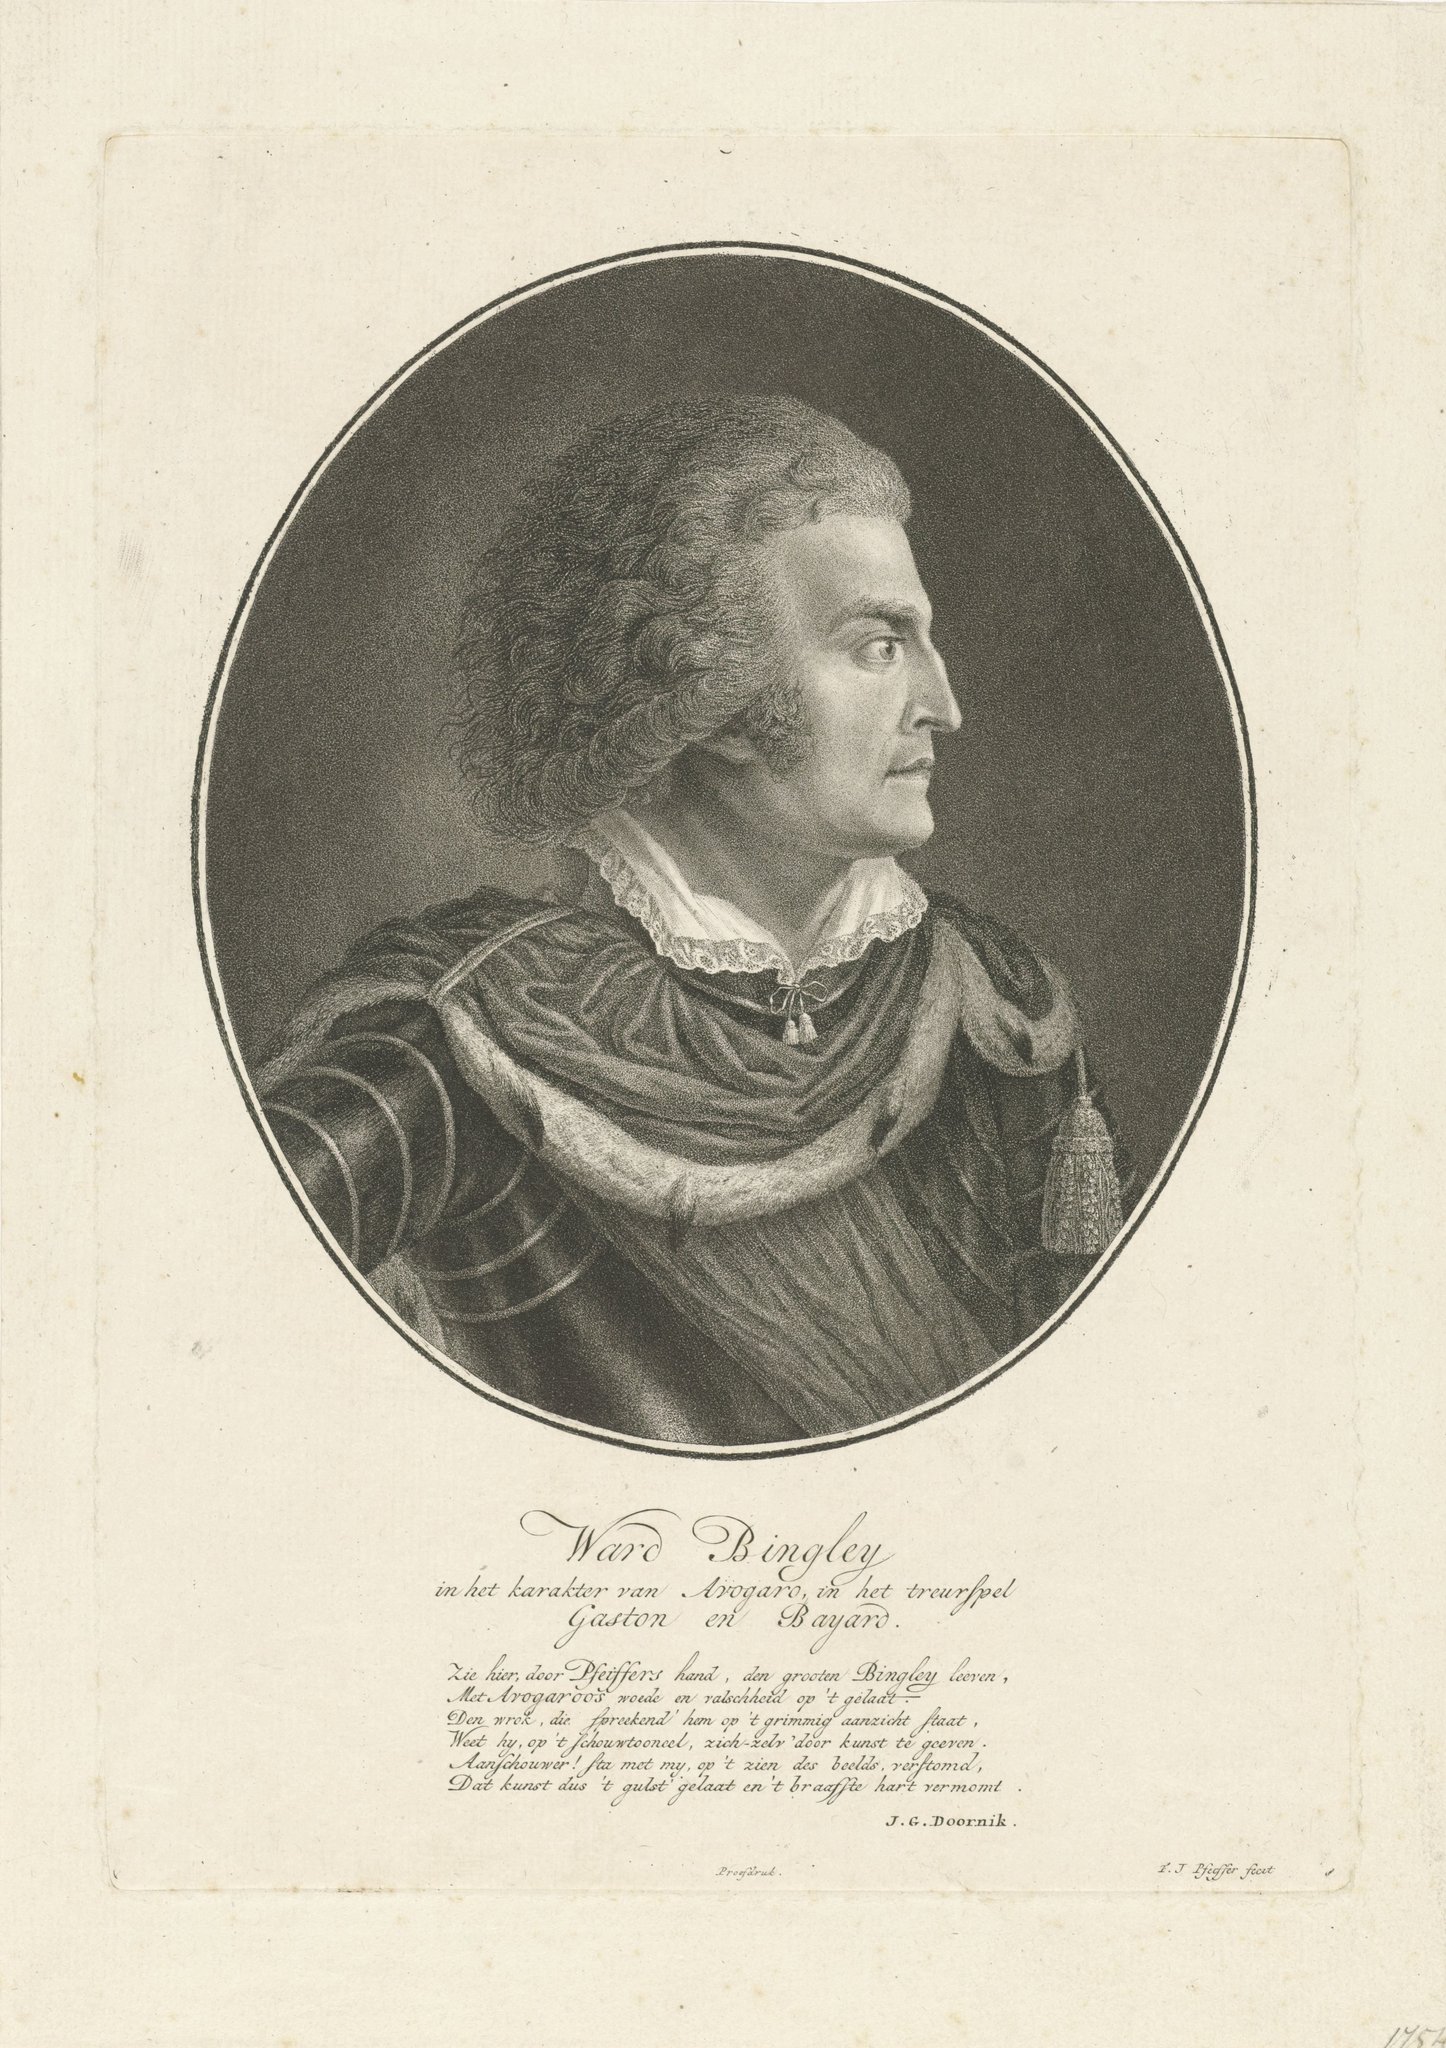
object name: print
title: Portret van Ward Bingley in de rol van Avogaro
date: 1787-1796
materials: paper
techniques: aquatint, etching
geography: amsterdam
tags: rotterdam, the hague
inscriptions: collector's mark: Lugt 2228